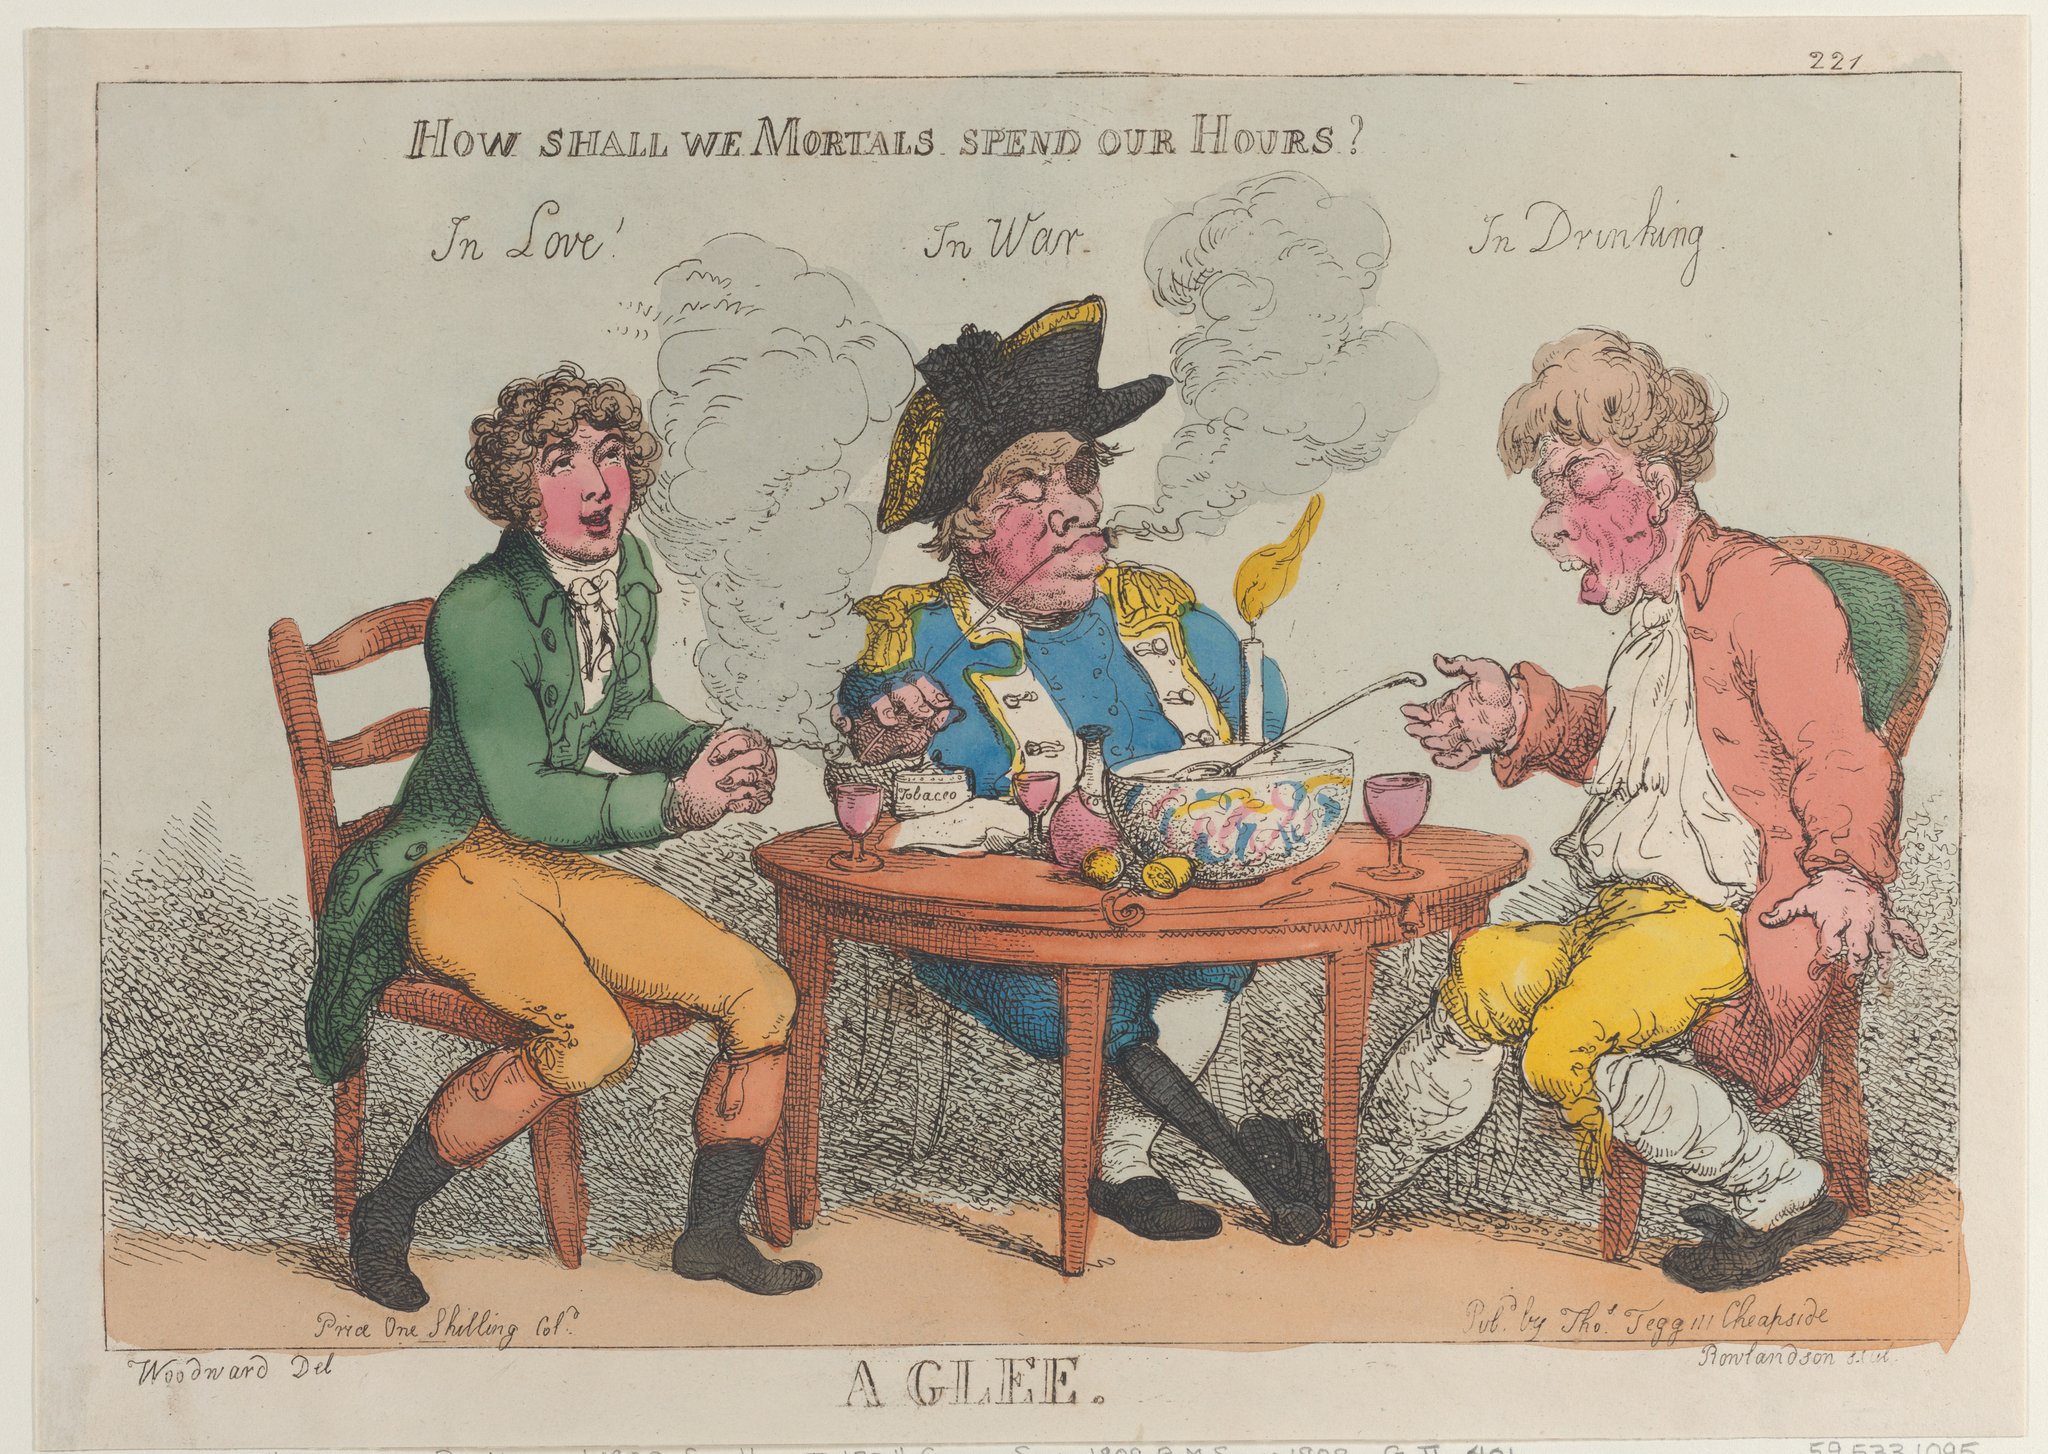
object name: print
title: A Glee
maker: thomas rowlandson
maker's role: artist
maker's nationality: british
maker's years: 1757-1827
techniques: etching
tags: satire,men,smoking